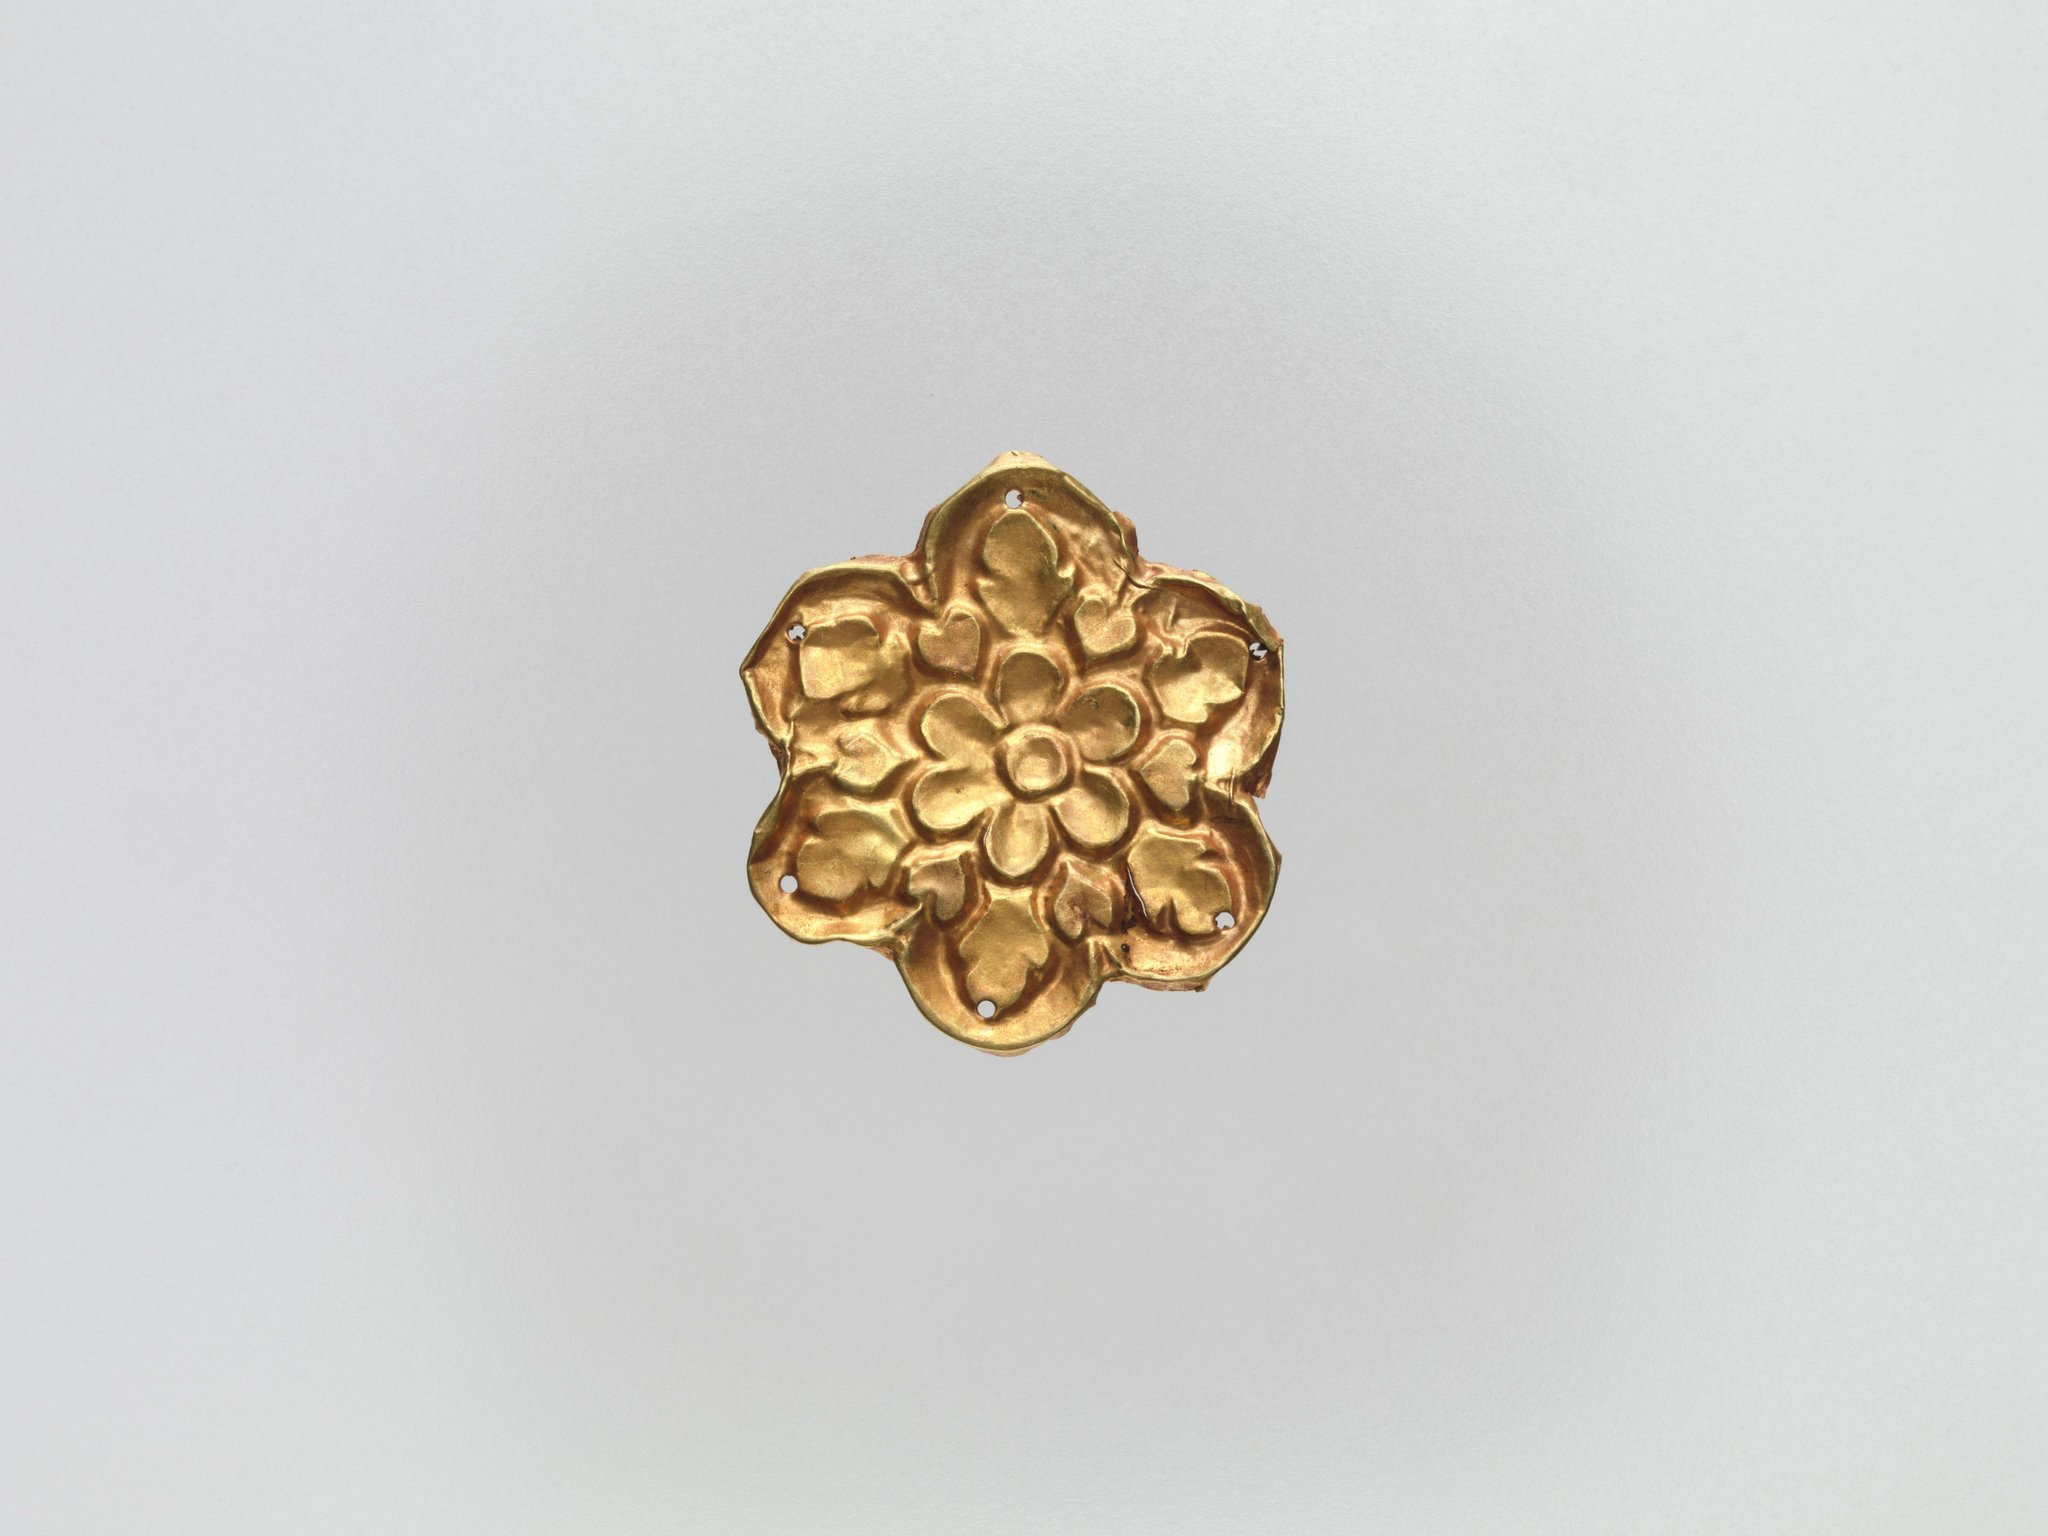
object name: garment plaque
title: Flower-Shaped Clothing Plaque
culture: chinese or central asian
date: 601-900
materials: gold